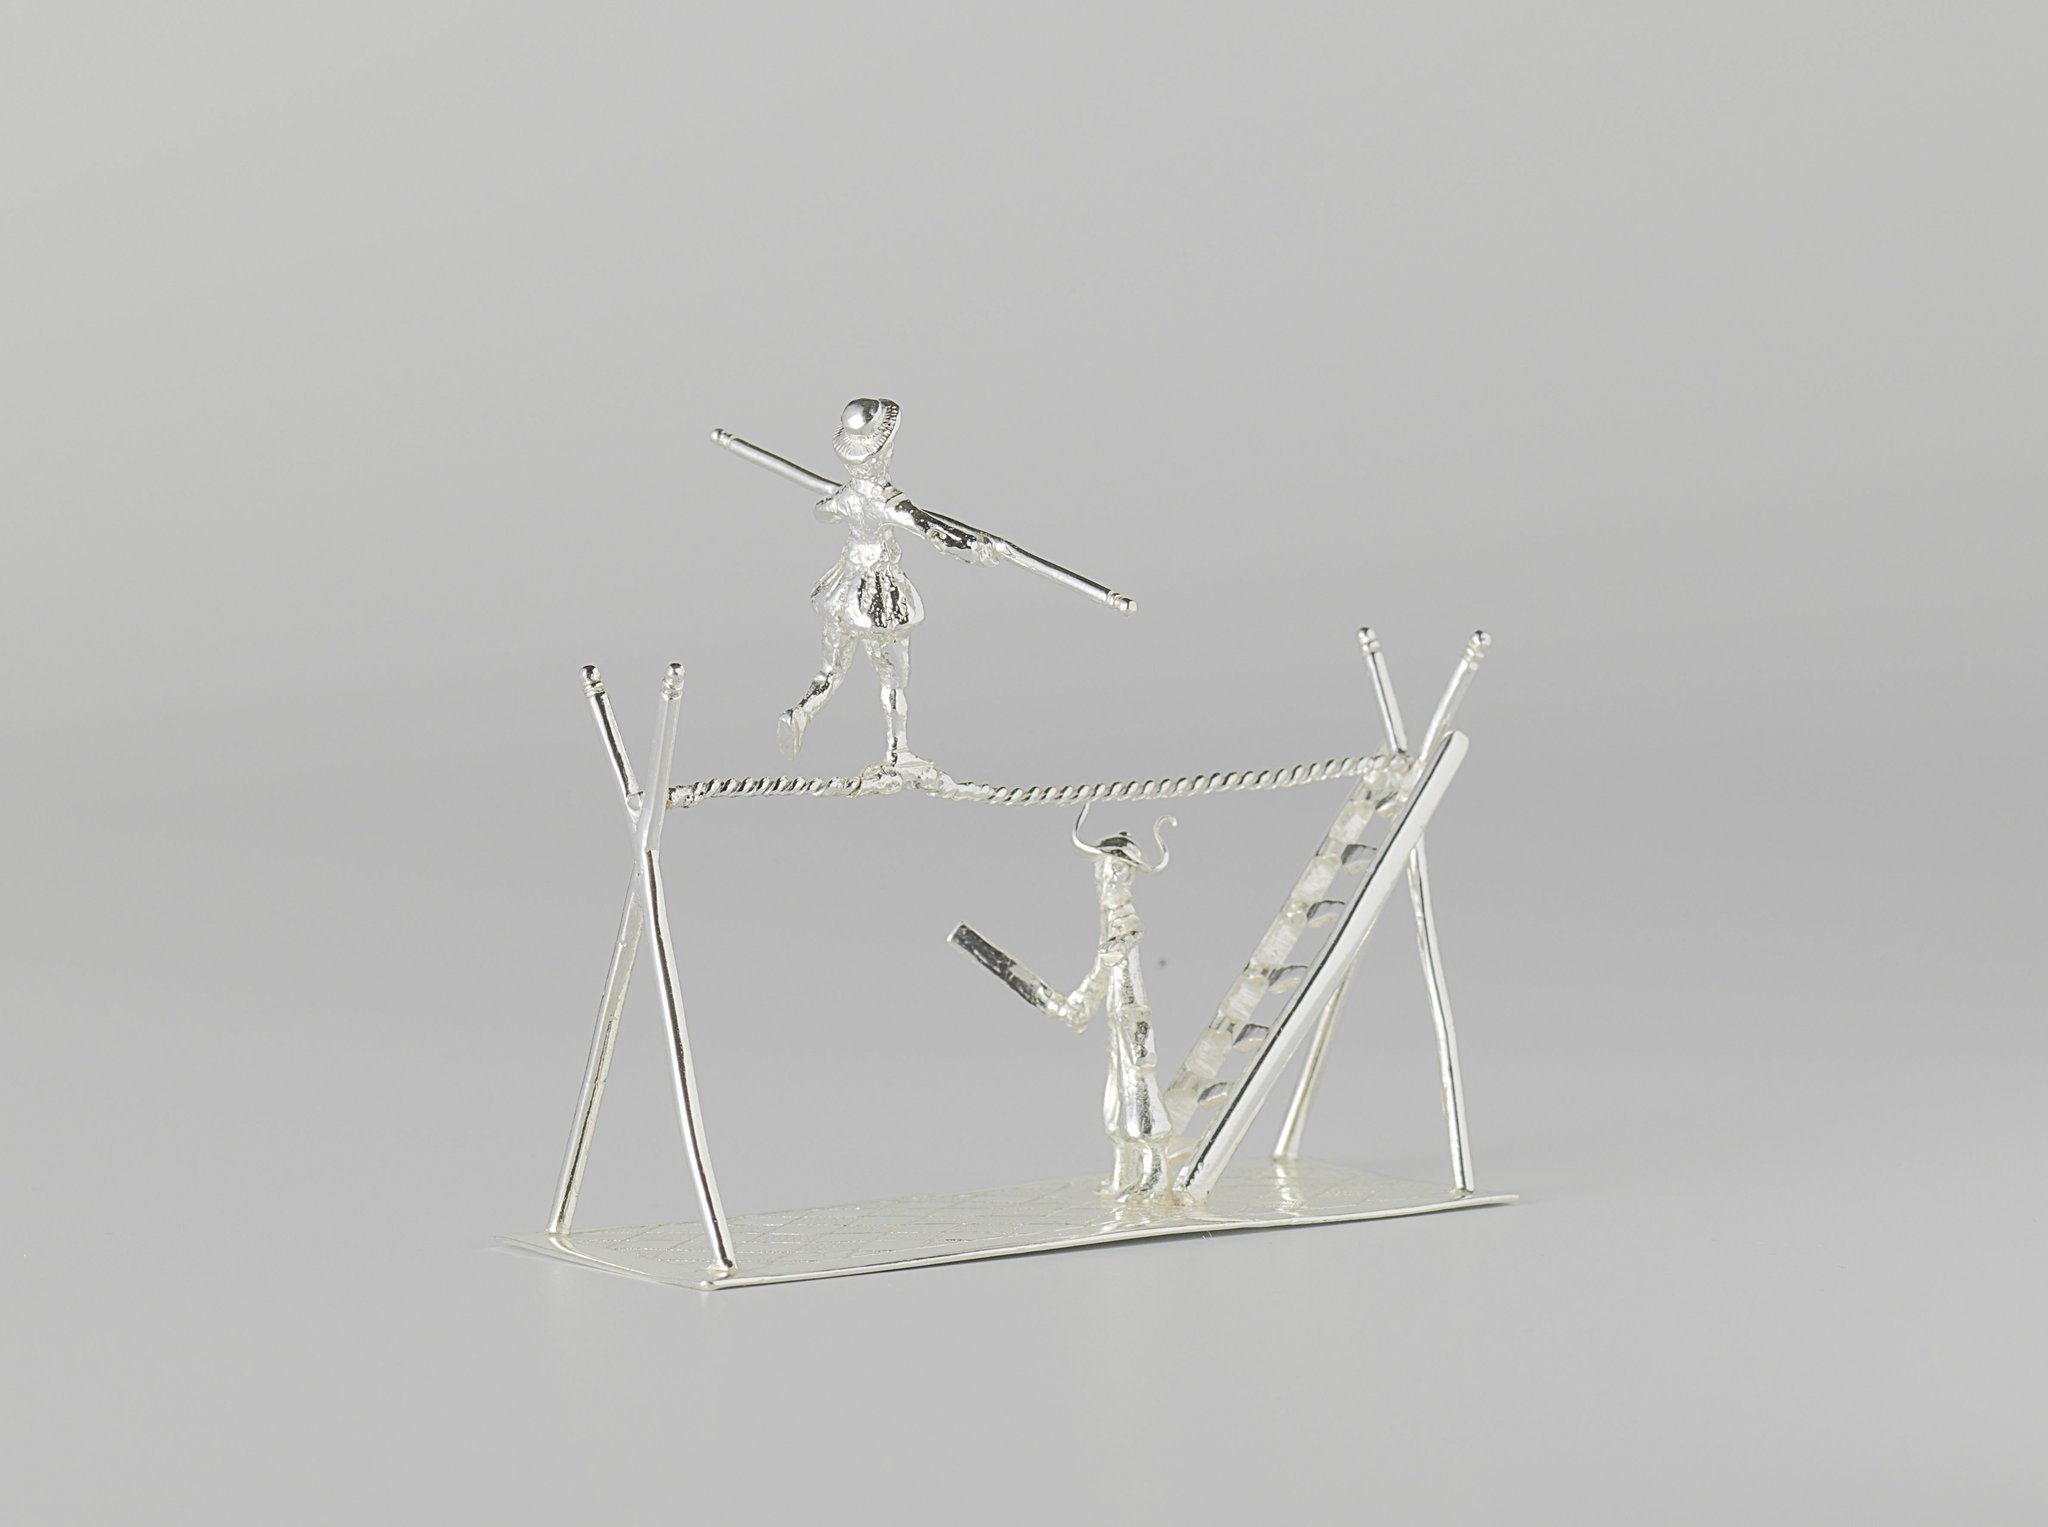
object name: miniature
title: Twee acrobaten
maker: michiel maenbeeck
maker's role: silversmith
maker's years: 1634-1682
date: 1662-1666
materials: silver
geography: amsterdam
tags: tight-ropewalker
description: Op een langwerpige plaat staan links en rechts twee gekruisde palen. Tussen de palen is een touw gespannen waarop een man balanceert. De man heeft een stok in zijn handen. Tegen de gekruisde palen aan een kant staat een ladder met daarvoor een man. De man heeft in zijn rechterhand een staaf en draagt een harlekijnshoed. In de plaat is een ruitpatroon gegraveerd. Het beeld is gemerkt: mt.= Michiel Maanbeeck en een gekroonde V in een wapen.